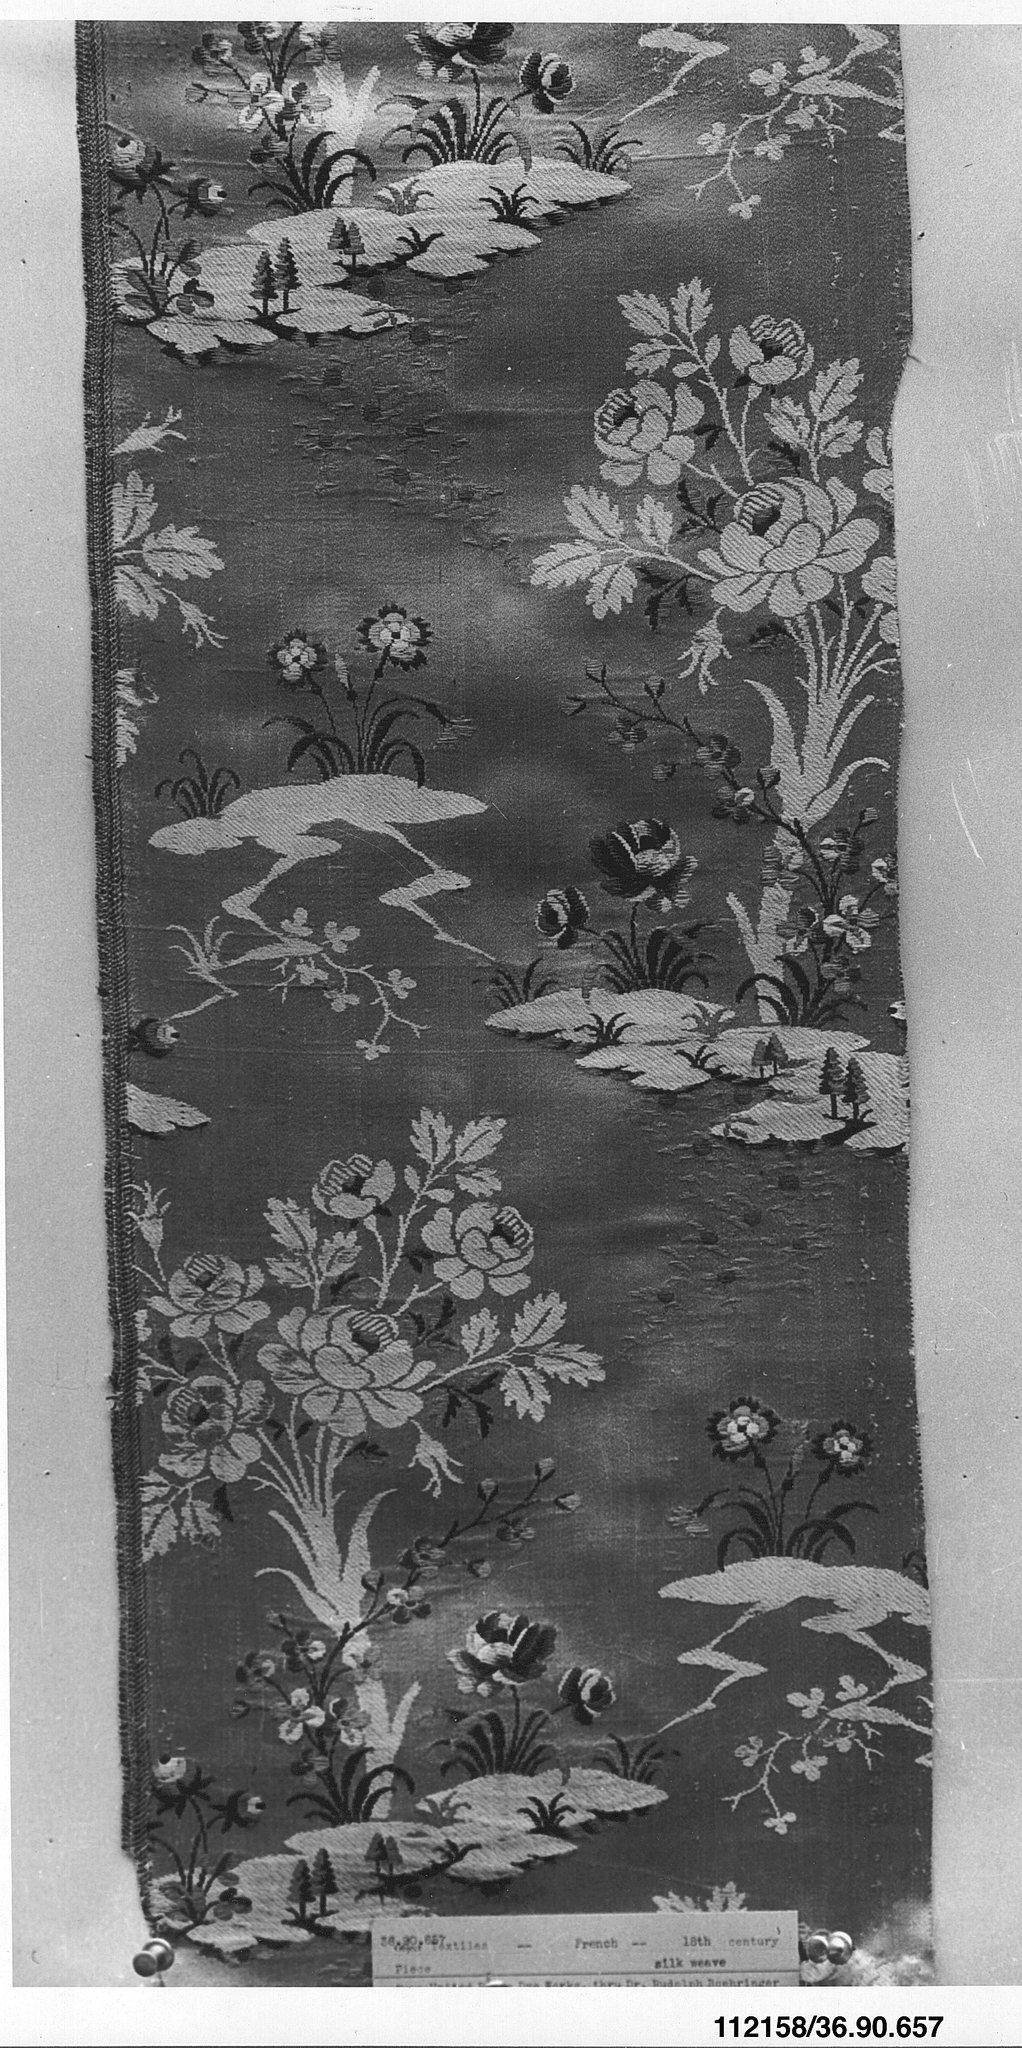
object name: piece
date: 1750-1760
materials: silk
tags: flowers